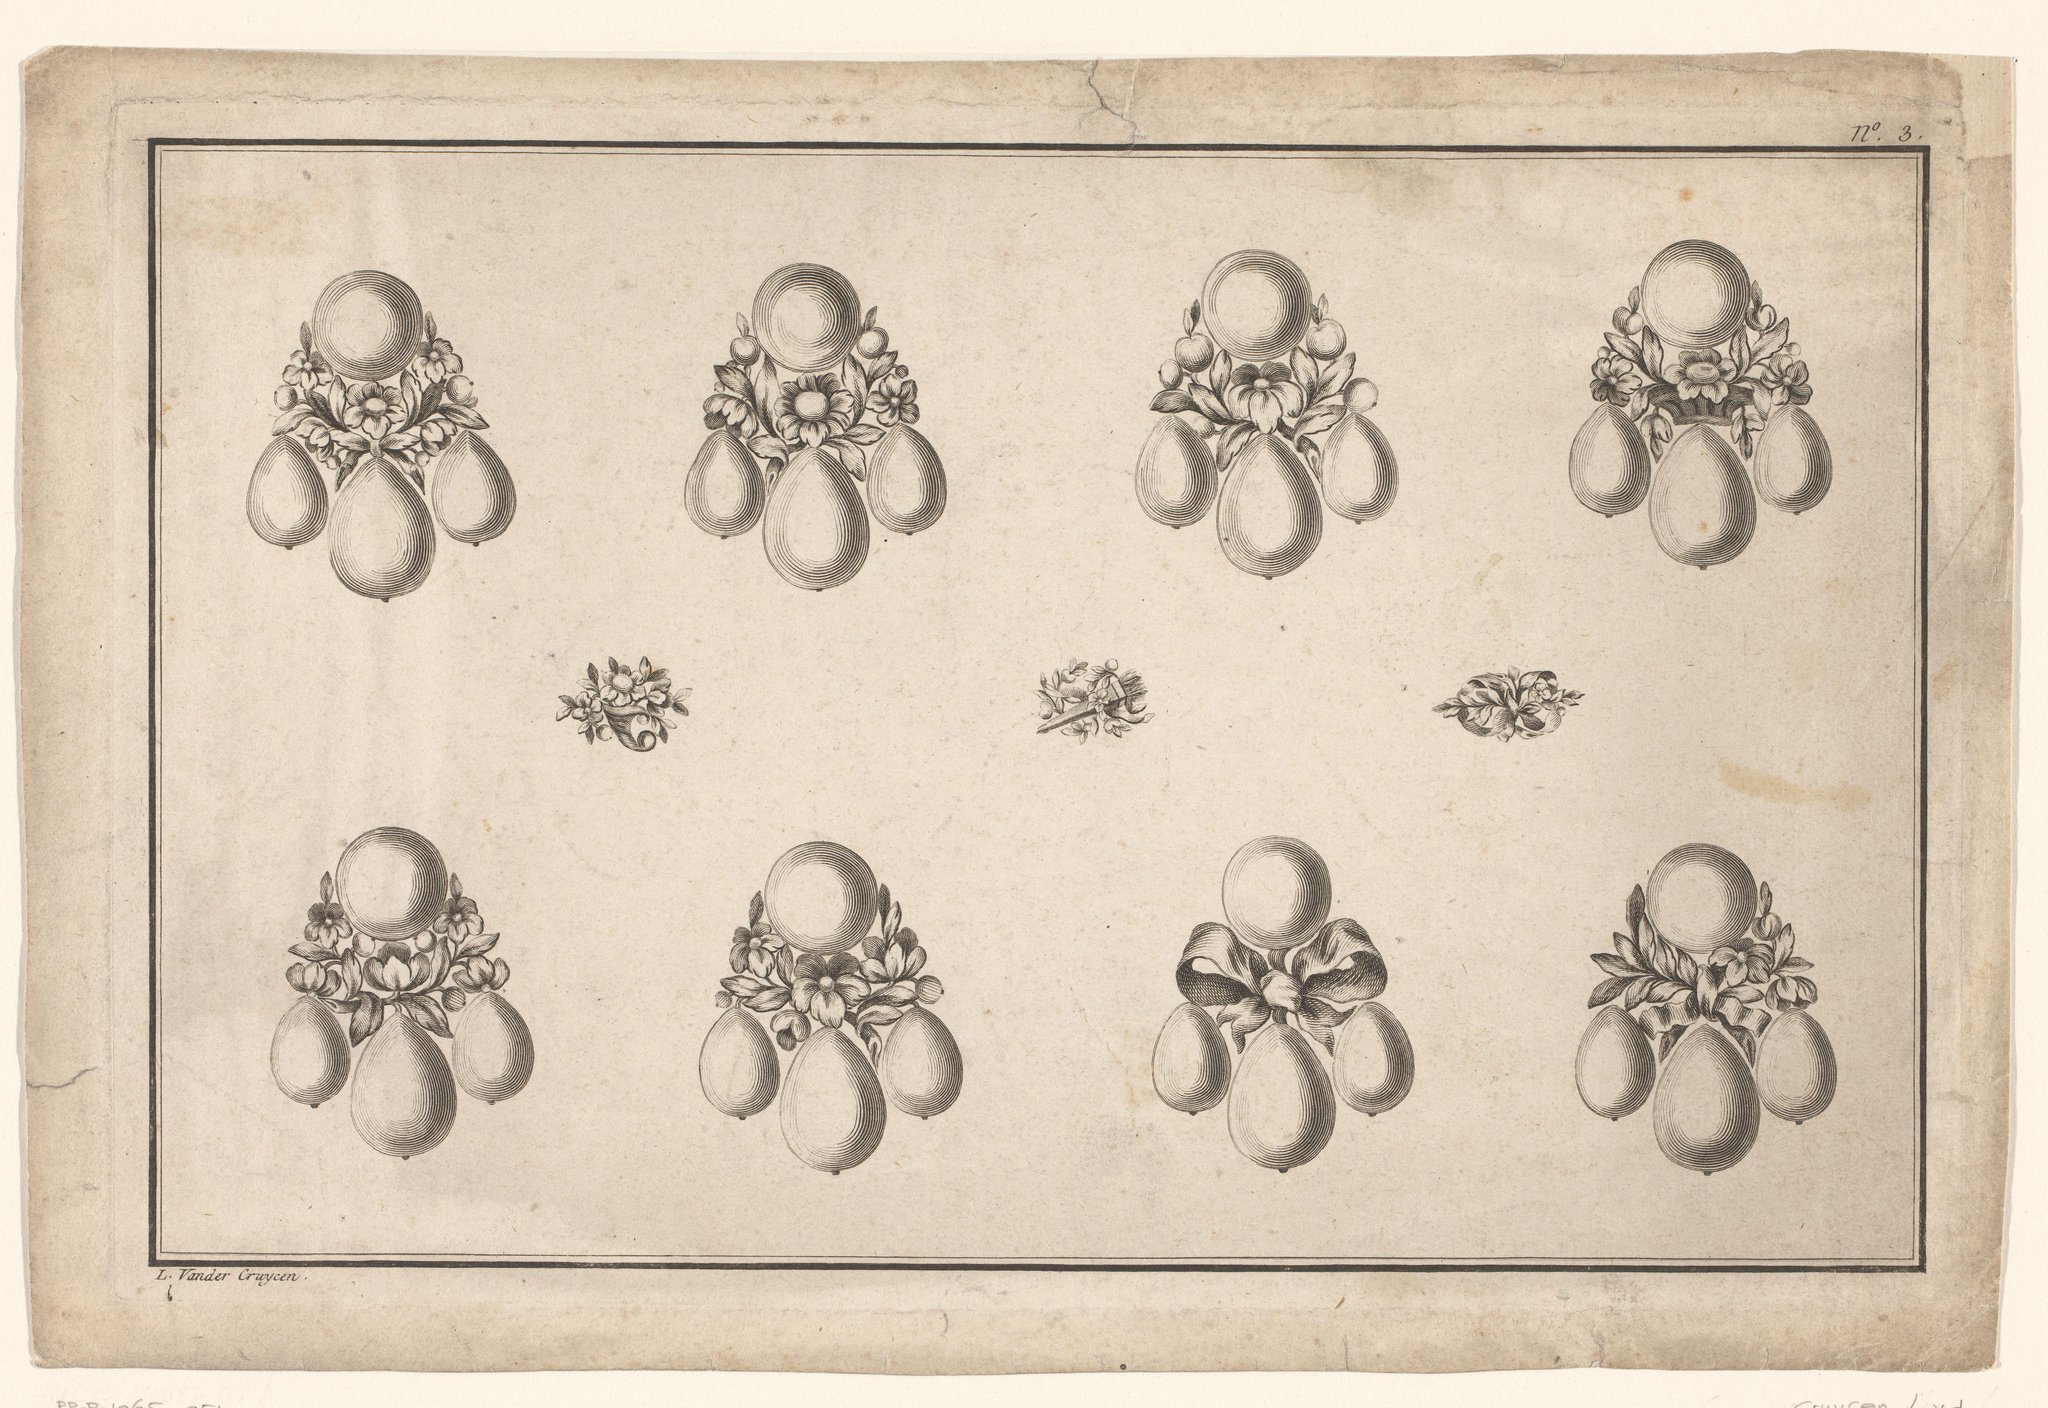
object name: ornament print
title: Designs for Earrings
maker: l. van der cruycen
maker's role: print maker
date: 1770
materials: paper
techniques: engraving, etching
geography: paris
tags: ear-rings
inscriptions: collector's mark: Lugt 2228, collector's mark: Lugt 2760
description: The eight earrings and brooches on this sheet are from a book full of jewellery in the Rococo style. Designs in the period 1750-1775 favoured natural forms, asymmetry, and rocailles, or shell motifs. The earrings are an example of the girandole style: three teardrop-shaped pearls dangle from a central element consisting of a bow or bouquet.